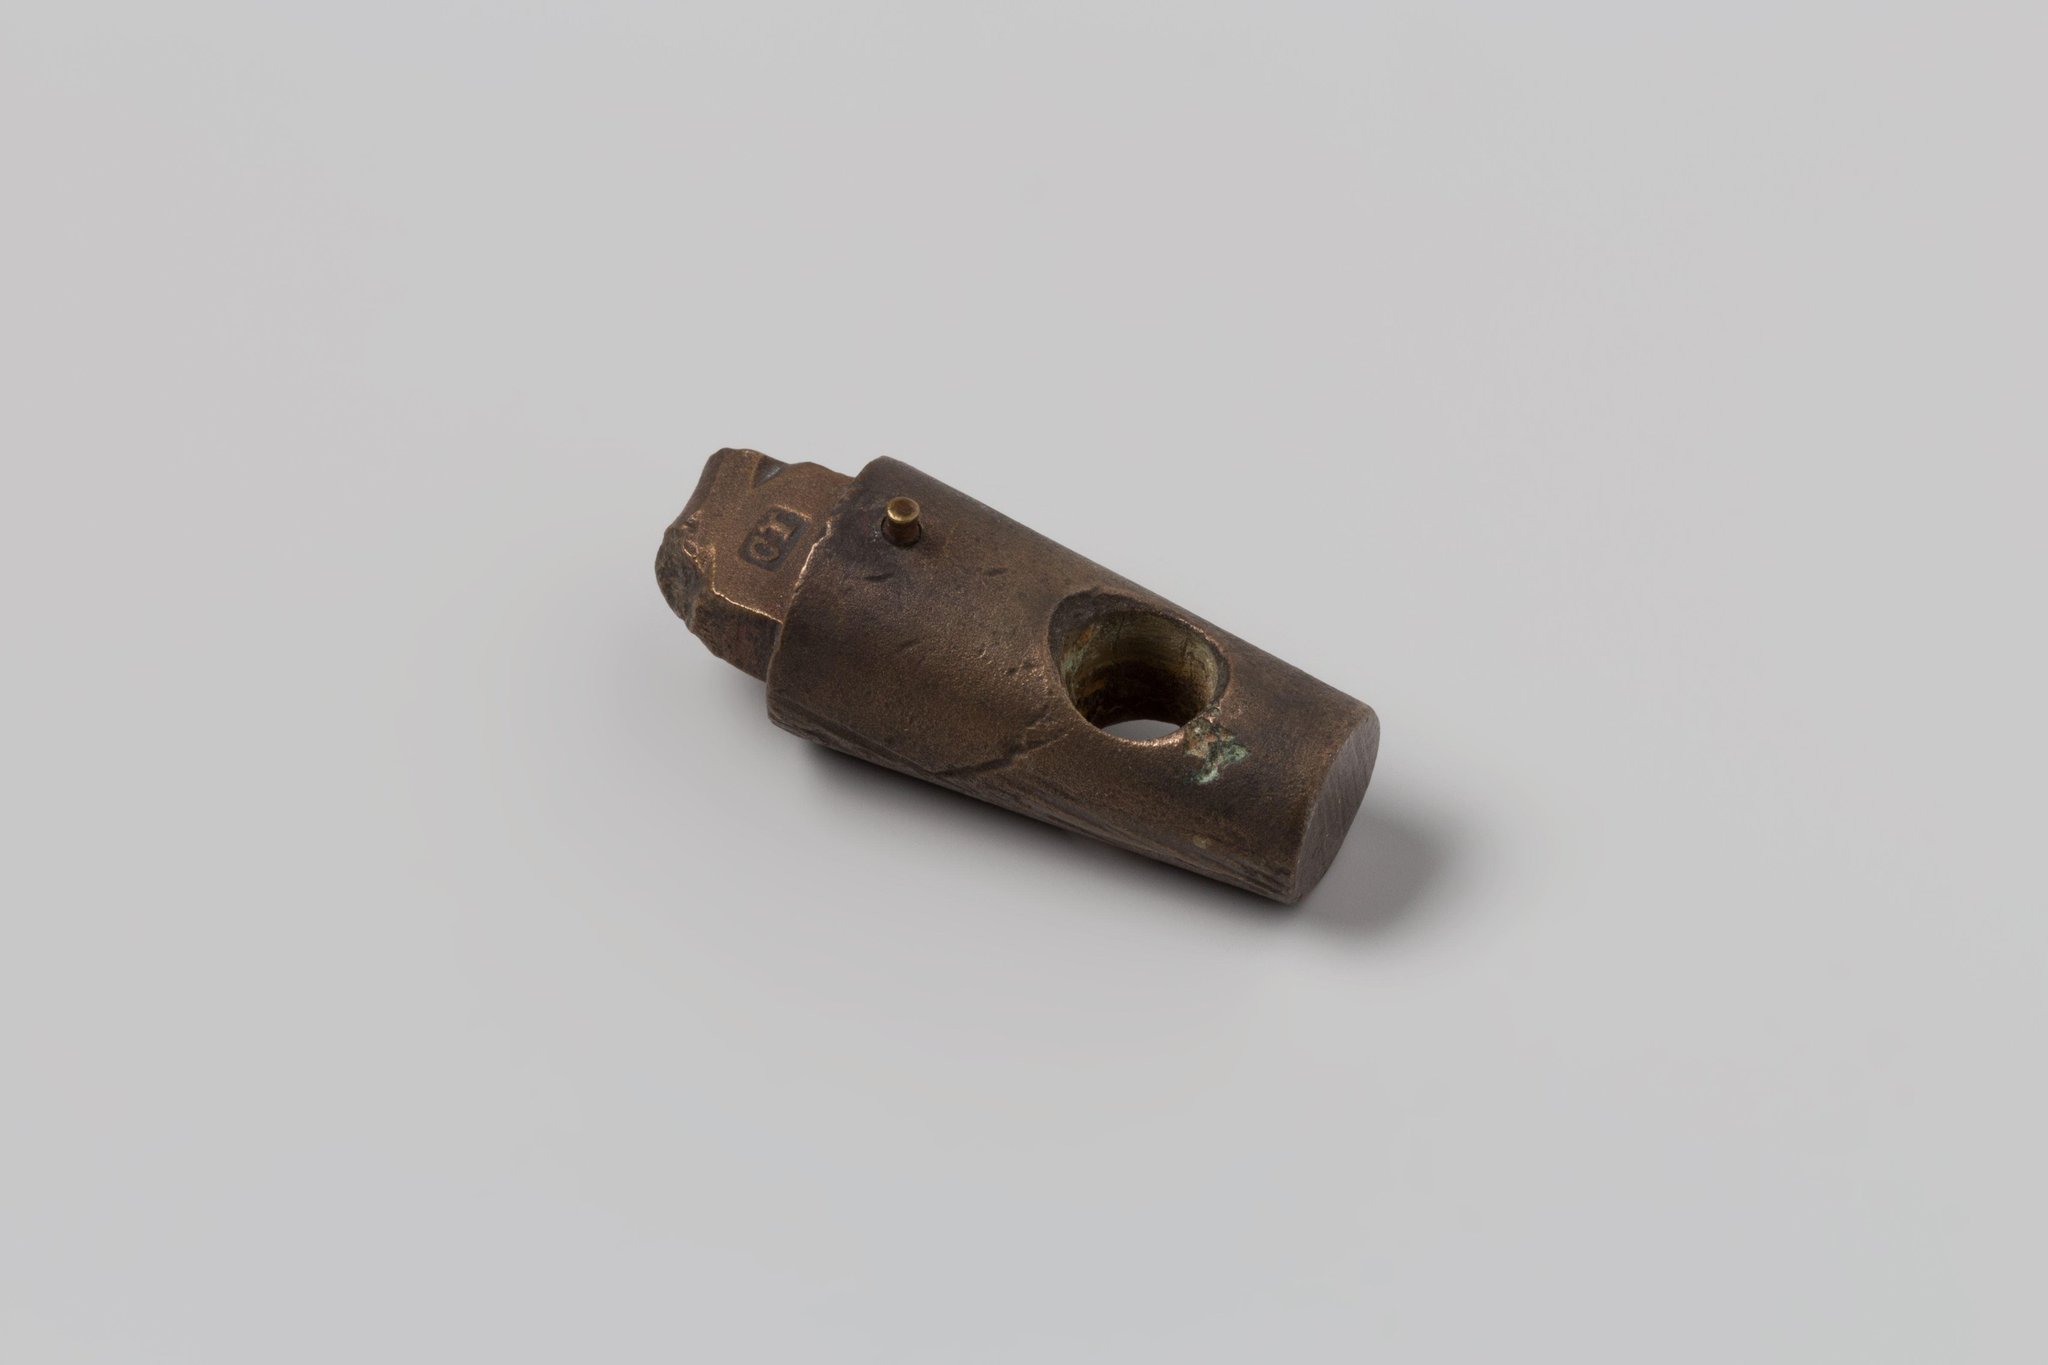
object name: spigot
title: Onderdeel tapkraan uit het wrak van de Oost-Indiëvaarder Hollandia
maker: Anonymous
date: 1700-1743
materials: copper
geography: netherlands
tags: verenigde oostindische compagnie, hollandia (schip), annet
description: Tap, spigot, removable; fragm, handle (ass. NG 1980-27H427) broken off, id. NG 1980-27H903, 2 marks on opposite sides legible [CT, cockerel].